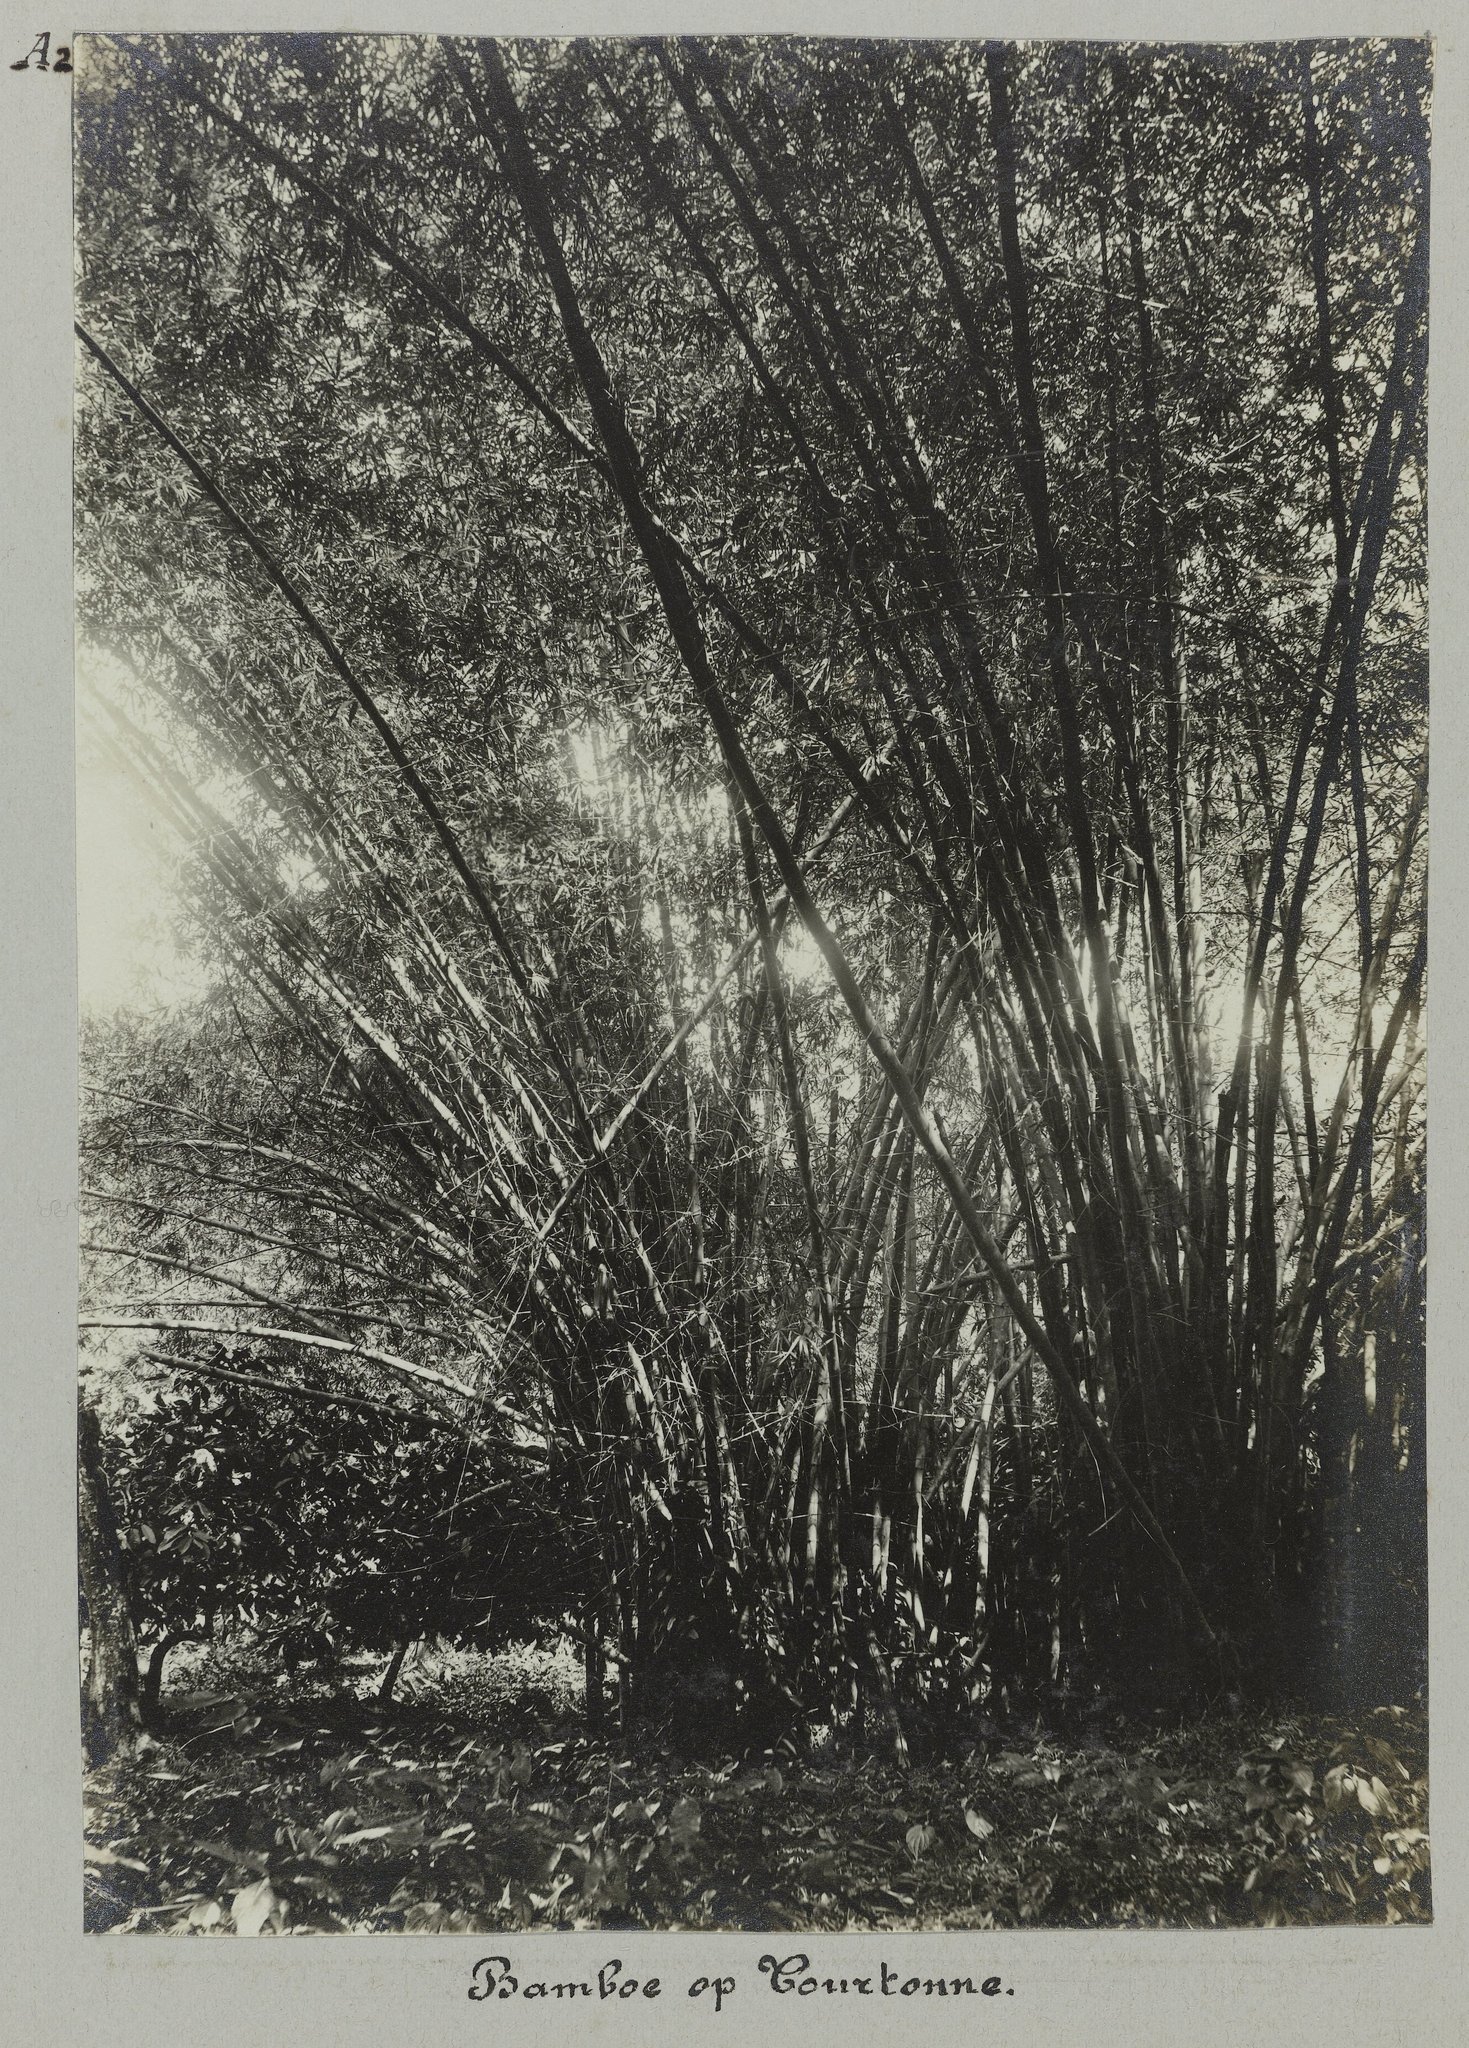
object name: photograph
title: Bamboe op Tourtonne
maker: hendrik doijer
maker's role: engineer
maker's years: 1863-1925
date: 1903-1910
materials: photographic support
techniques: gelatin silver print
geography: suriname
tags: suriname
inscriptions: inscription: ‘A2 / Bamboe op Tourtonne.’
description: Hoge bamboestruik op de plantage Tourtonne. Onderdeel van het fotoalbum Souvenir de Voyage (deel 1), over het leven van de familie Doijer in en rond de plantage Ma Retraite in Suriname in de jaren 1903-1910.